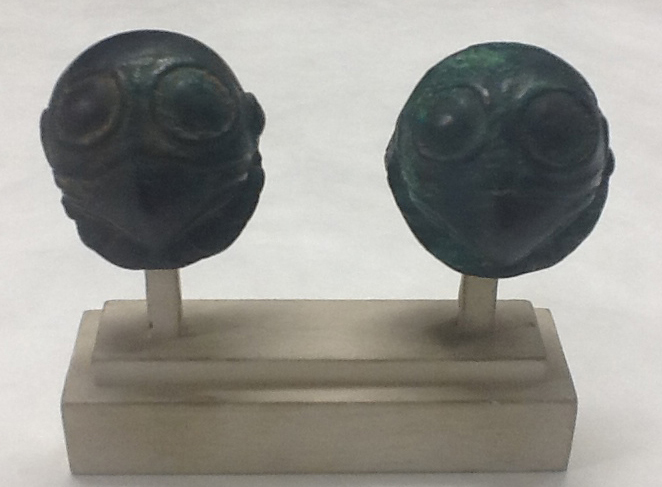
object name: ornament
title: One of a pair of Bird-Head Ornaments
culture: chinese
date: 300-1 BCE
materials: bronze